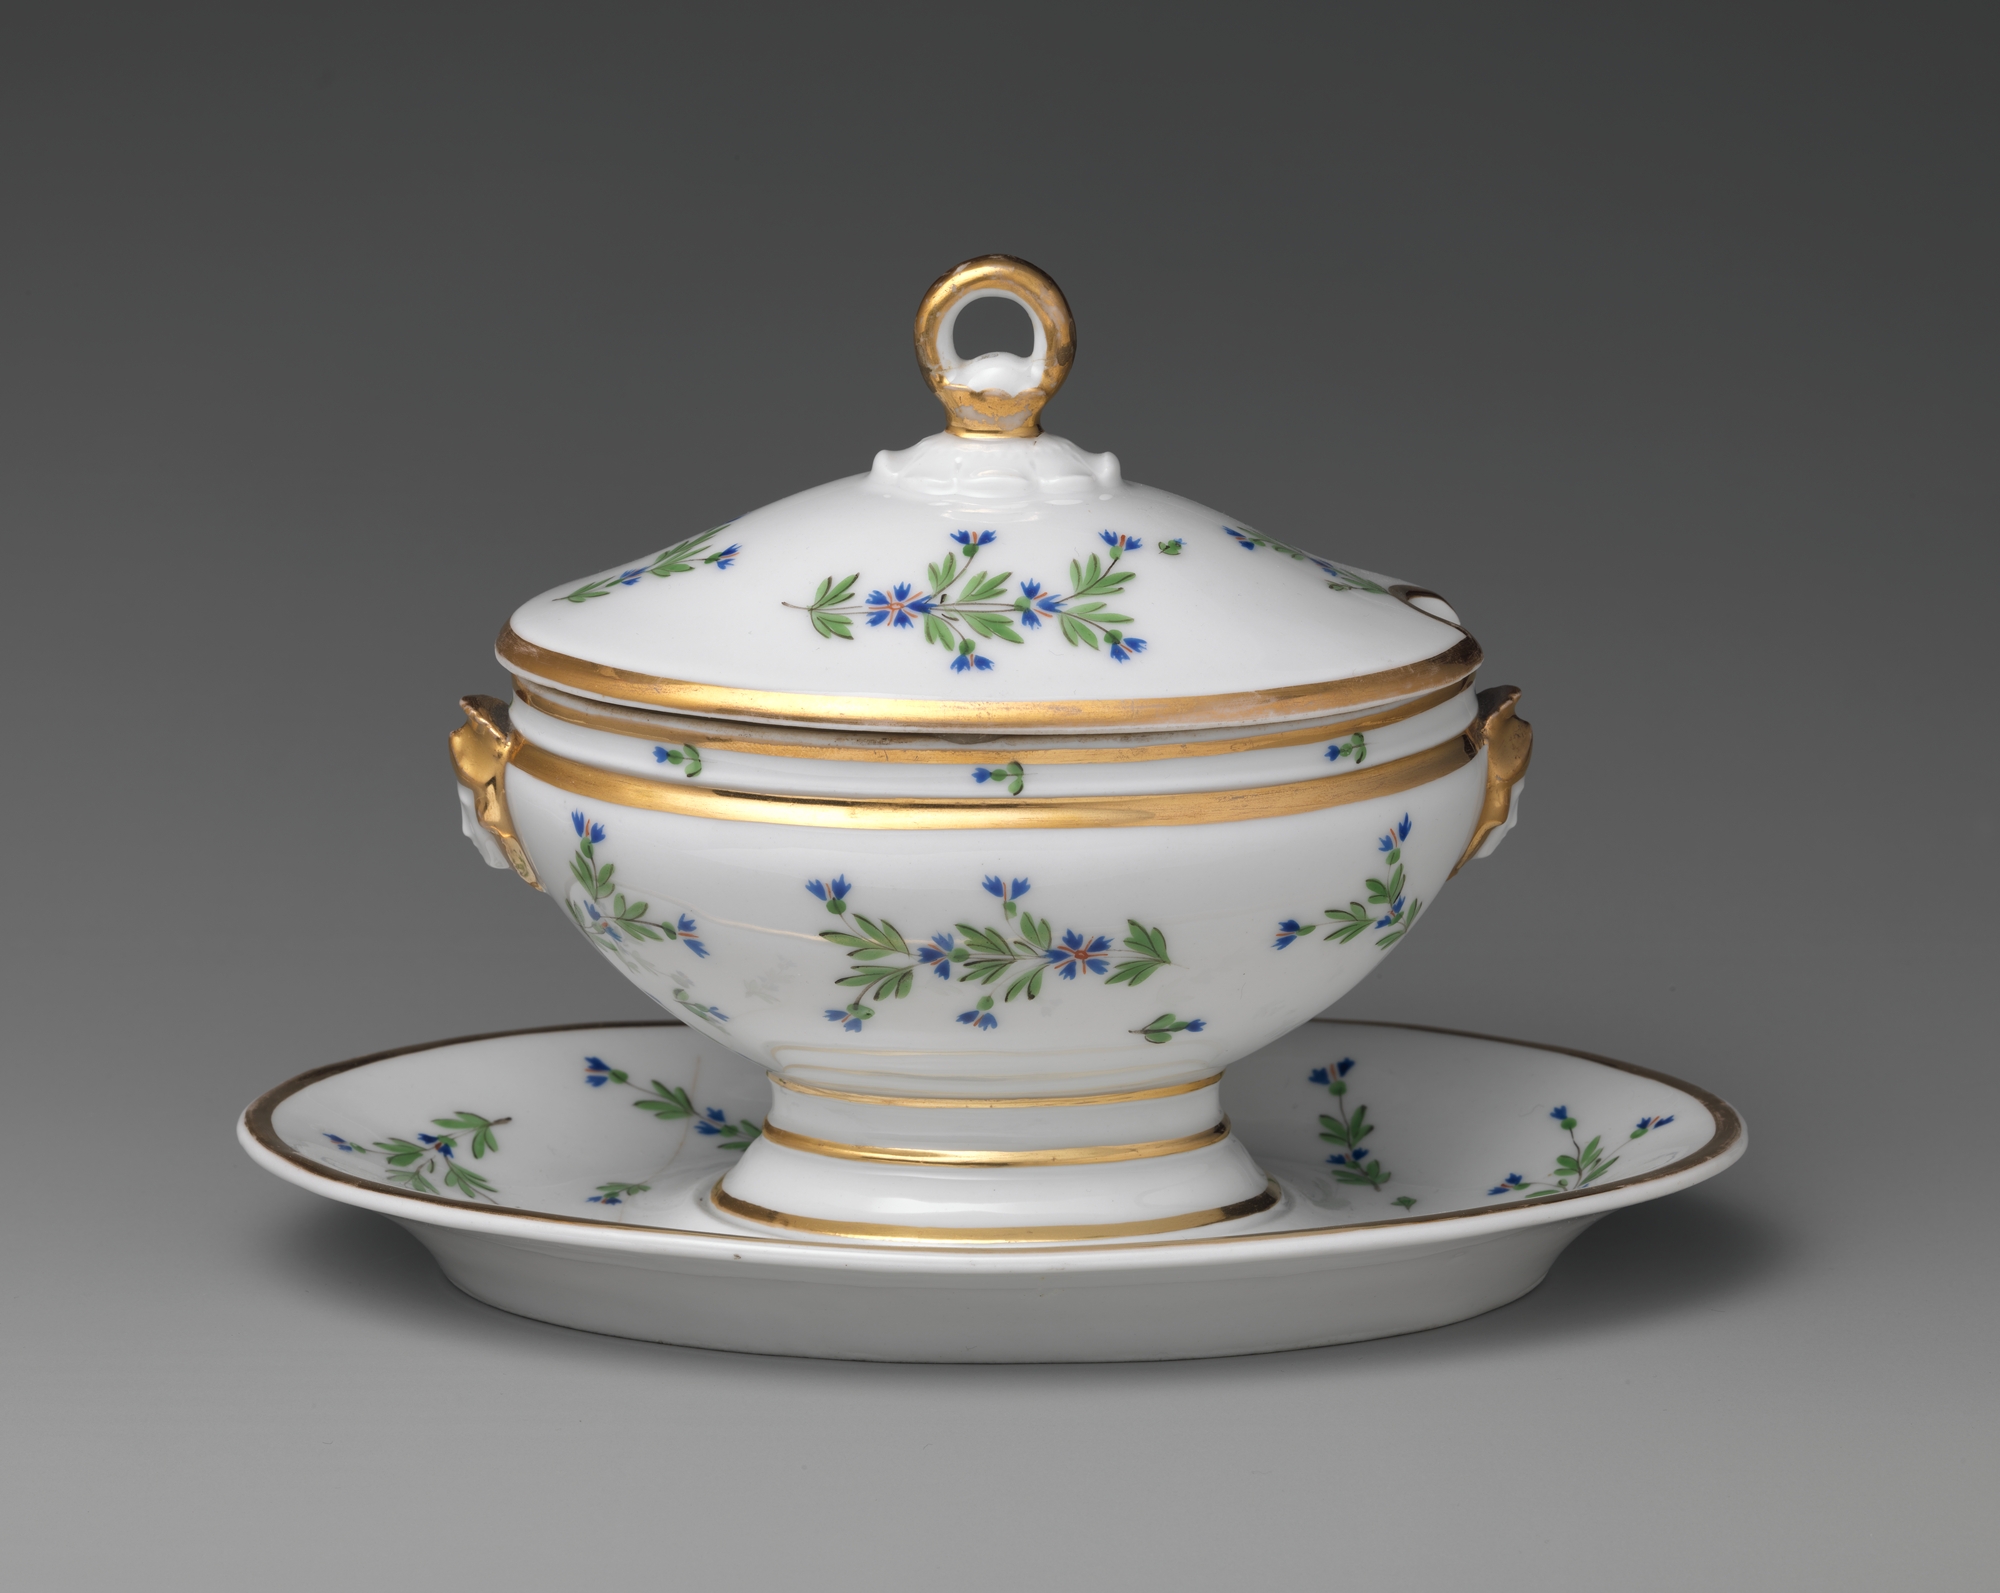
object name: bowl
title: Covered Bowl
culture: french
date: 1815-1830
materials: porcelain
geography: france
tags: flowers